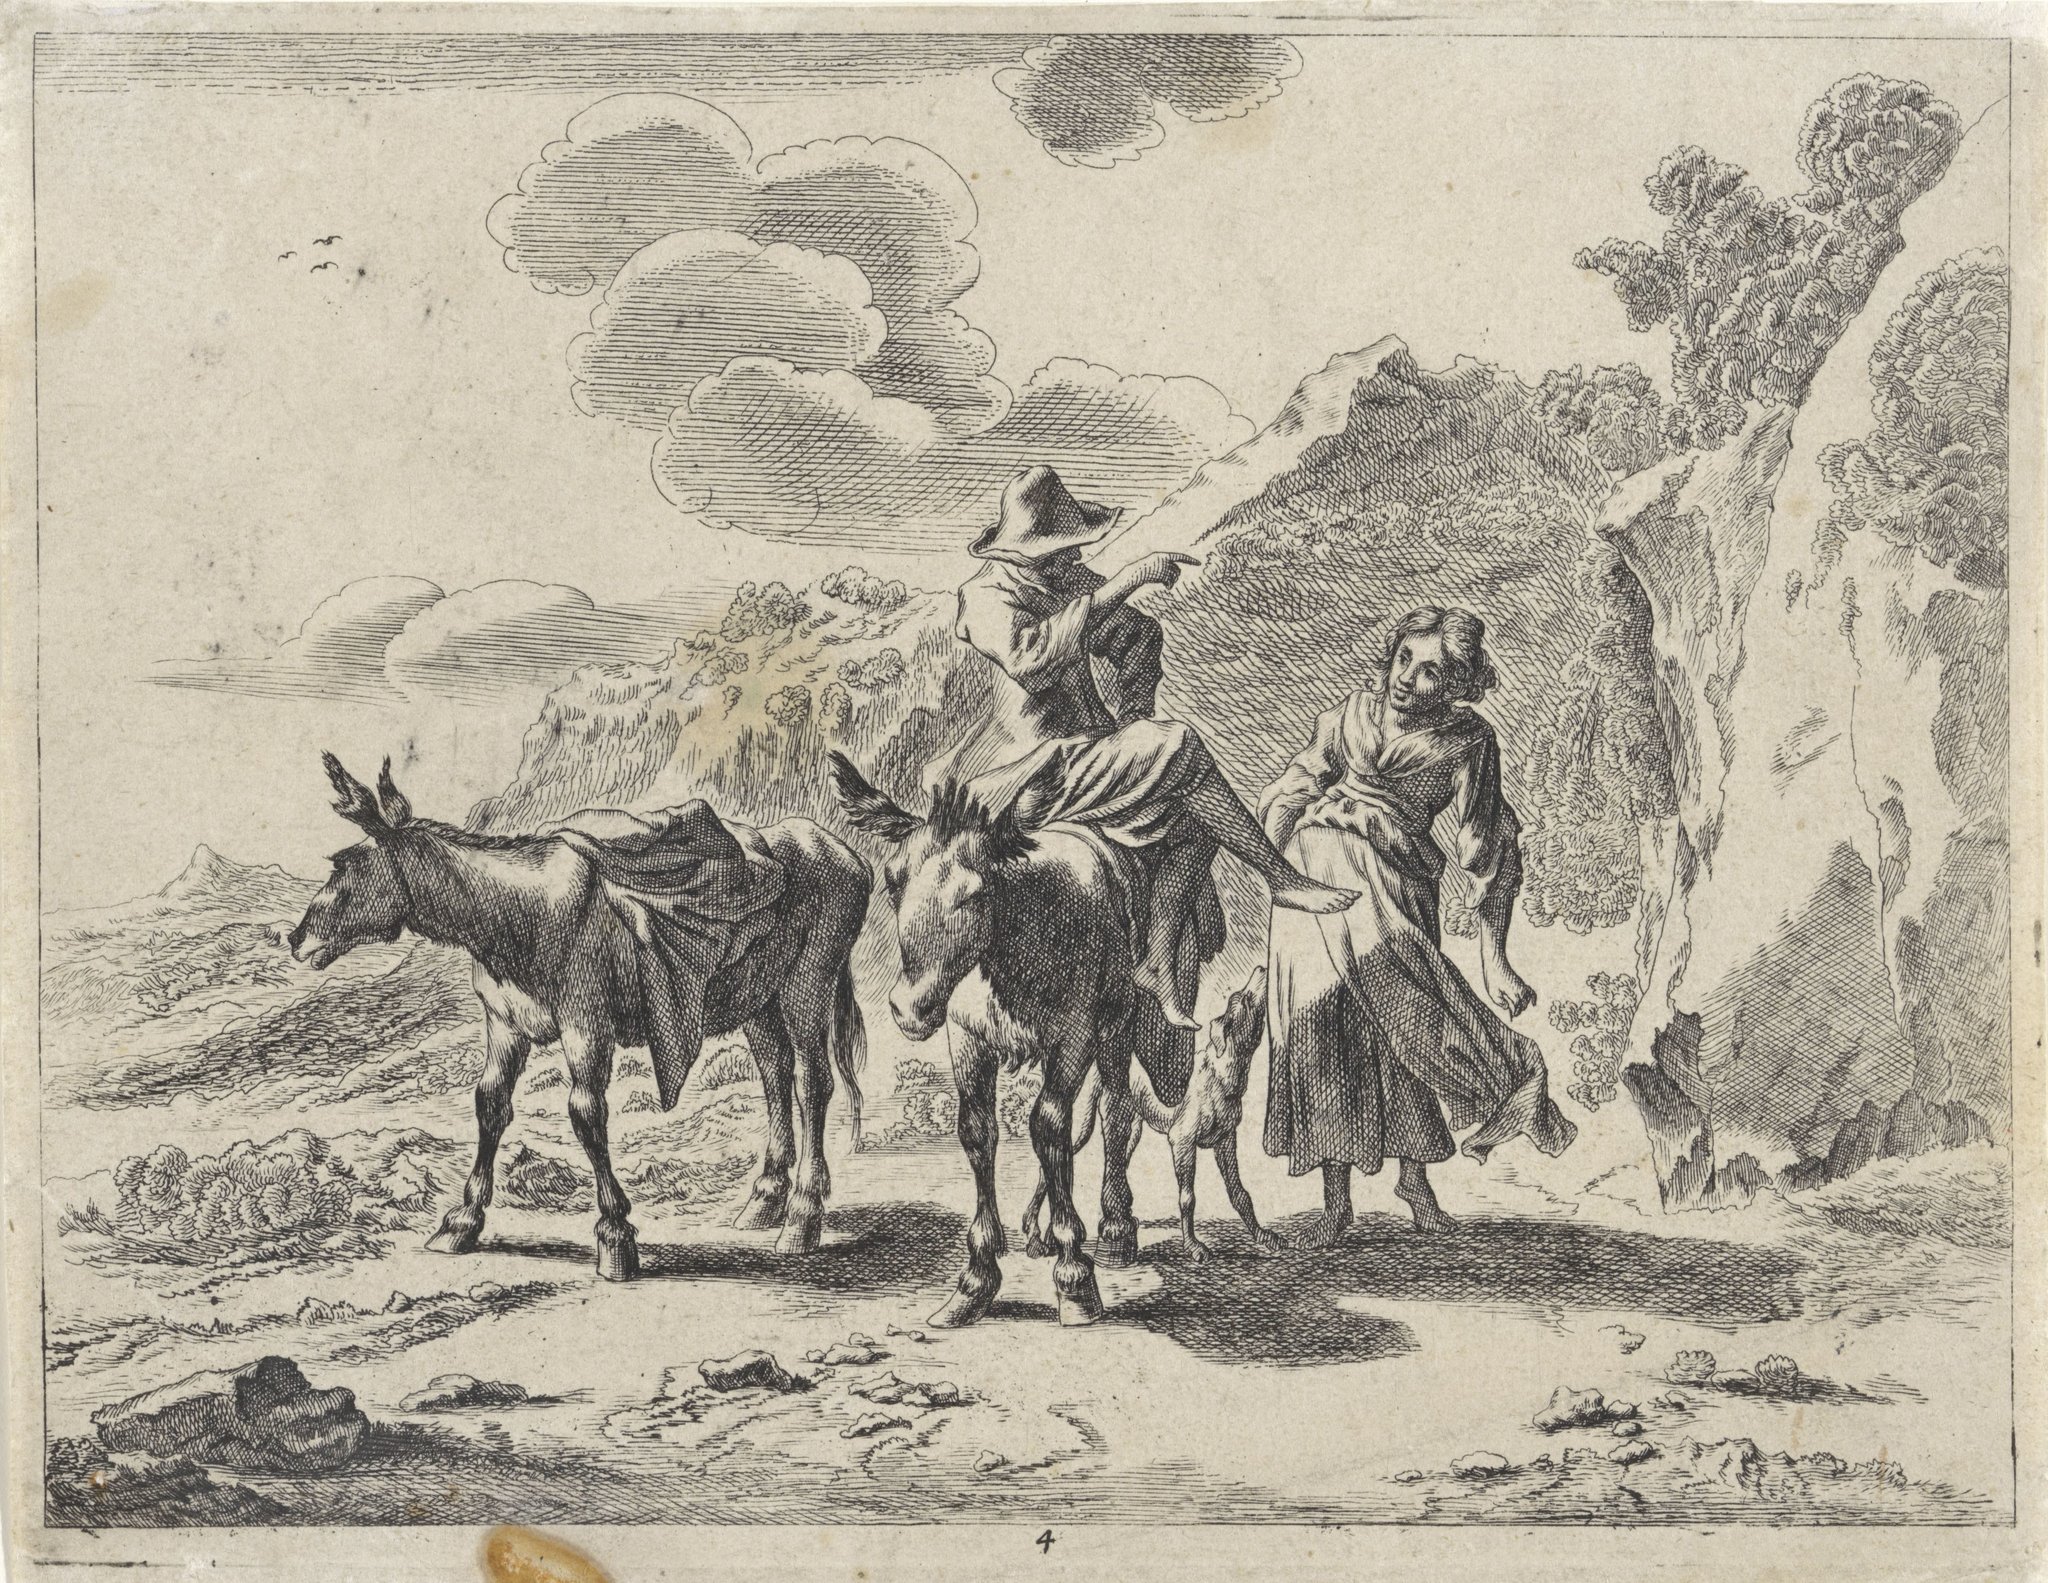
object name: print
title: Jonge herder op een ezel en een herderin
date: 1677-1690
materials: paper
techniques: engraving, etching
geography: amsterdam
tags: landscapes, ass, donkey, herding, herdsman, herdswoman, shepherd, shepherdess, cowherd, etc.